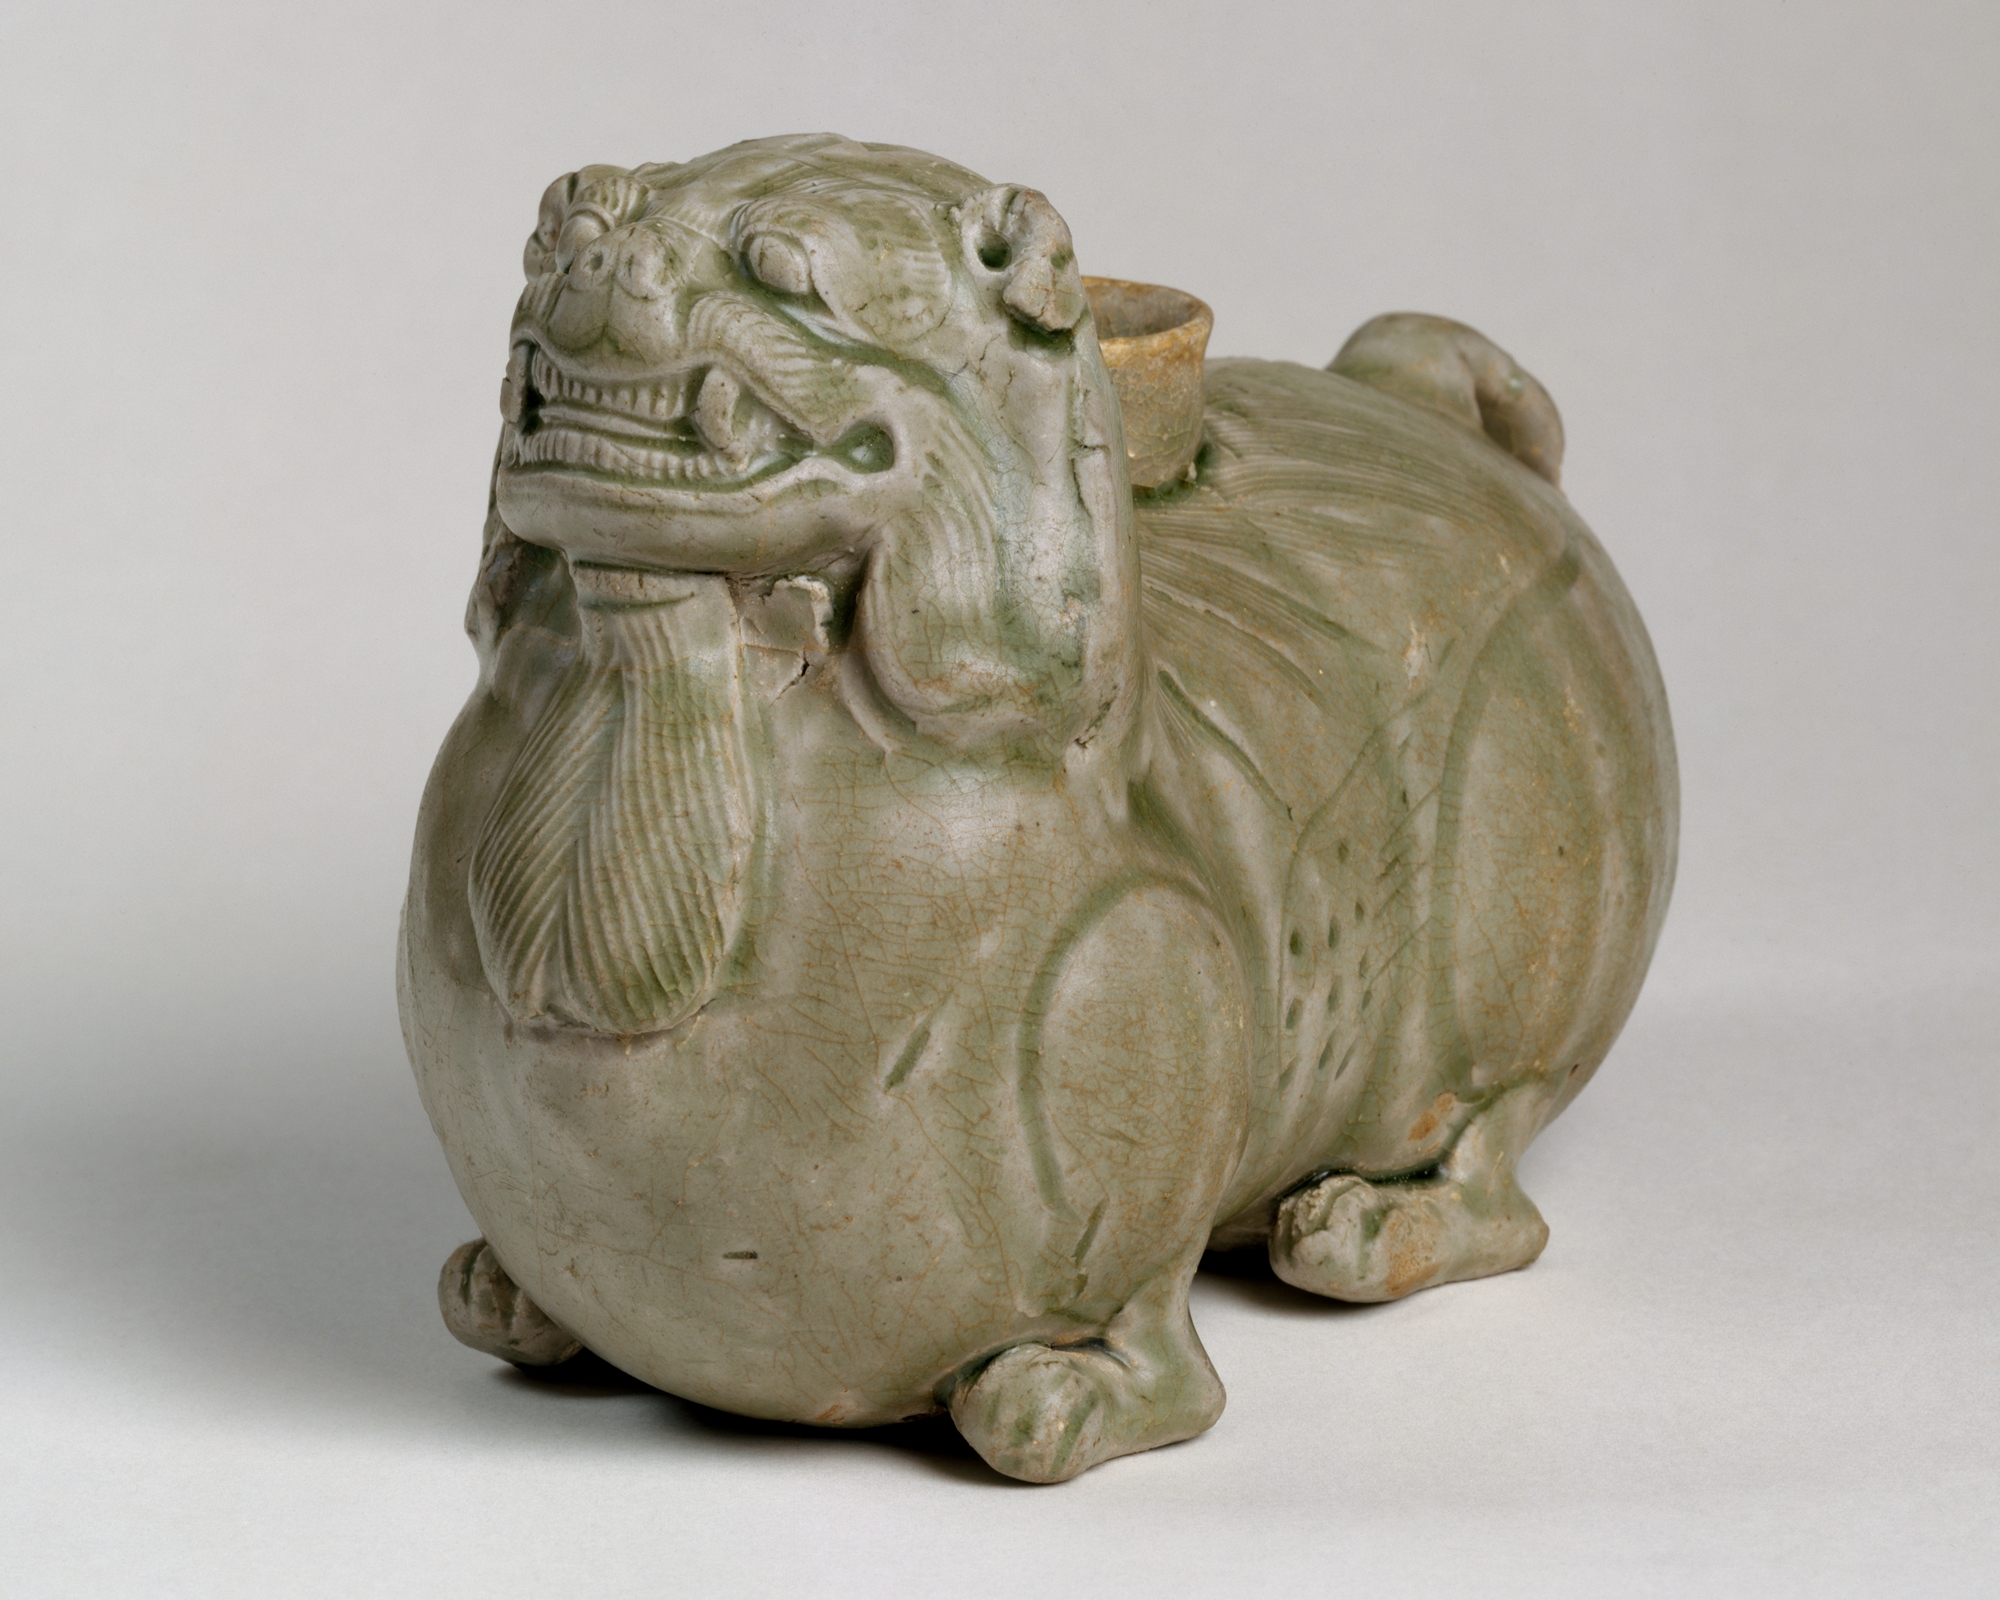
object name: vessel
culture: chinese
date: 265-316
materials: ceramic glaze, glaze, stoneware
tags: animals